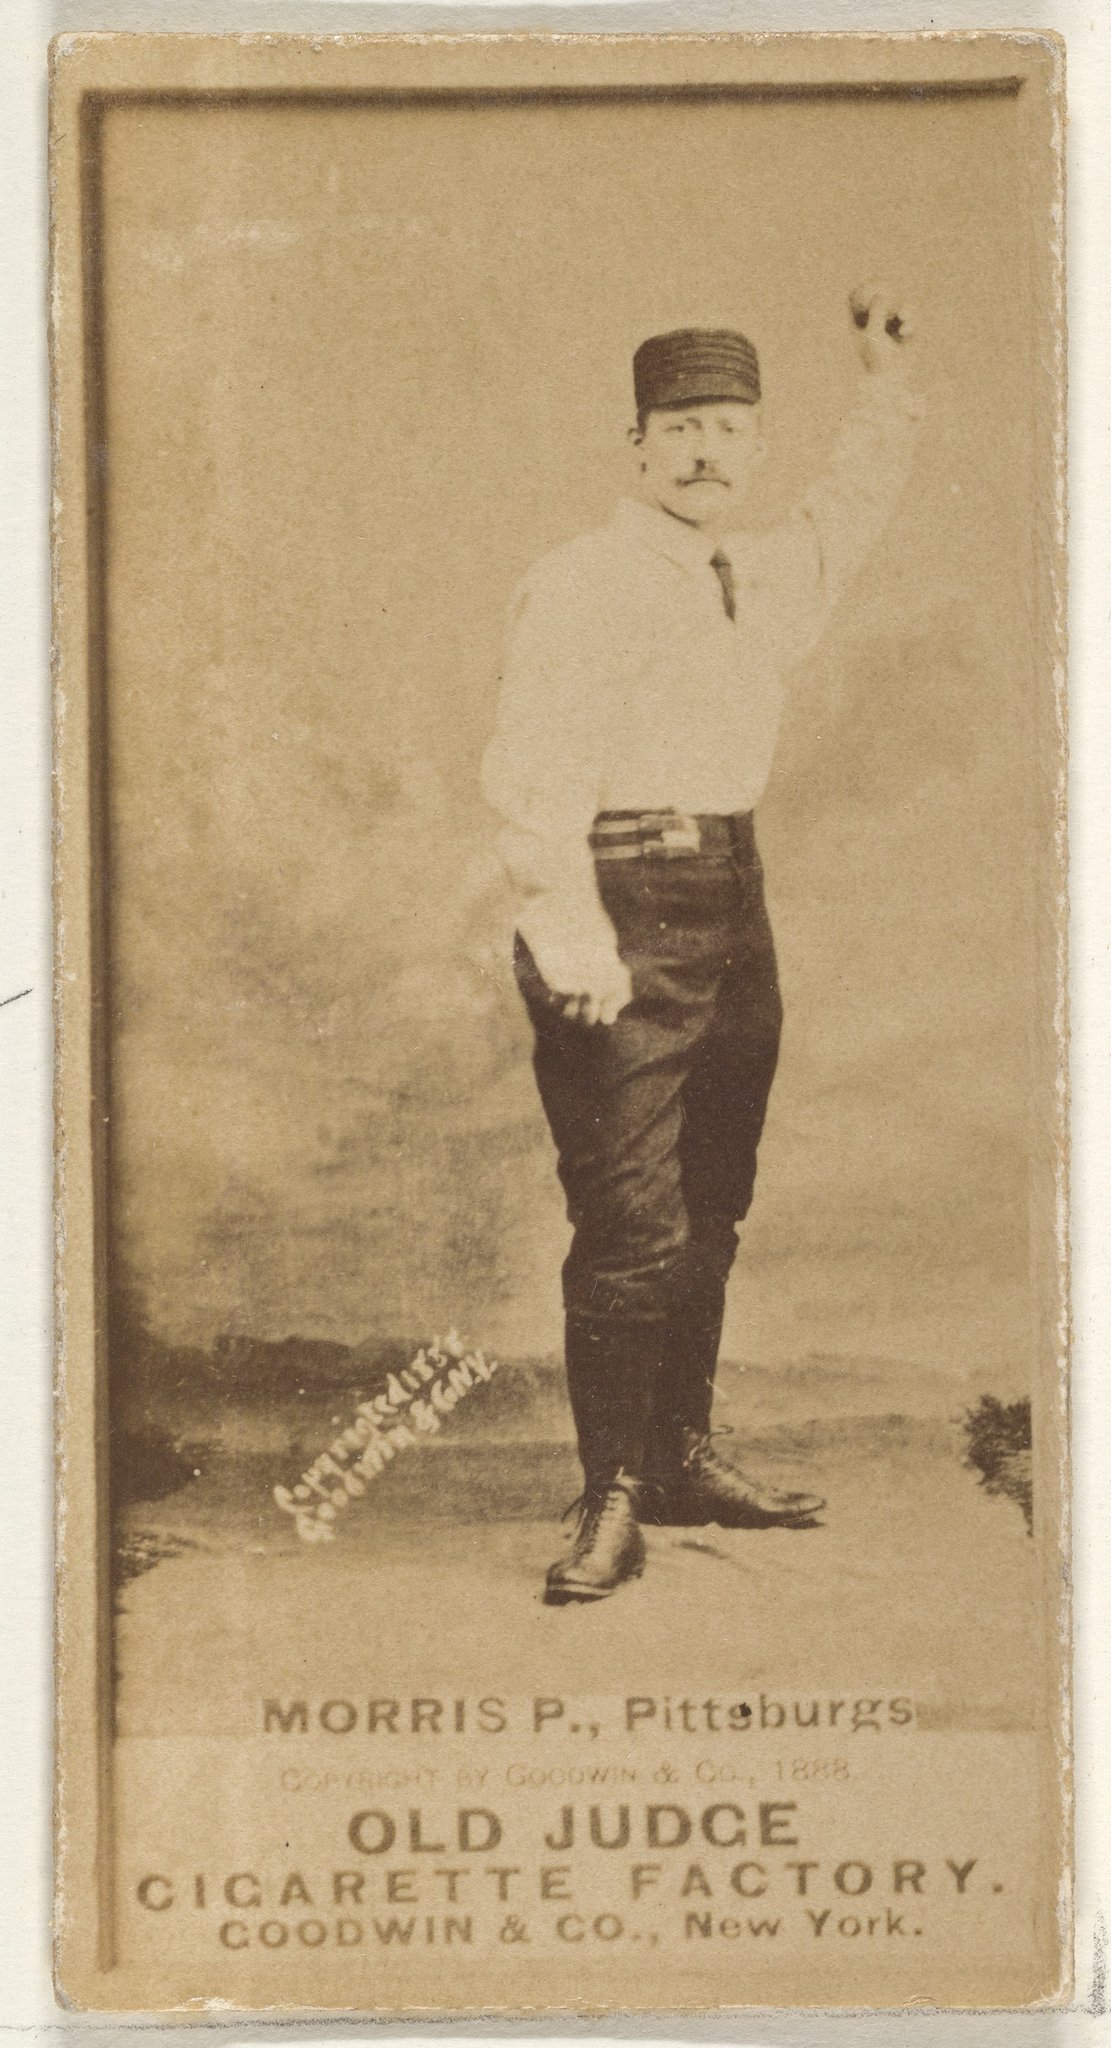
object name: baseball card, photograph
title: Ed Morris, Pitcher, Pittsburgh, from the Old Judge series (N172) for Old Judge Cigarettes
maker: goodwin & company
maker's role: publisher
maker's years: 1850-1950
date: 1888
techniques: albumen silver print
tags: men,portraits,baseball,athletes